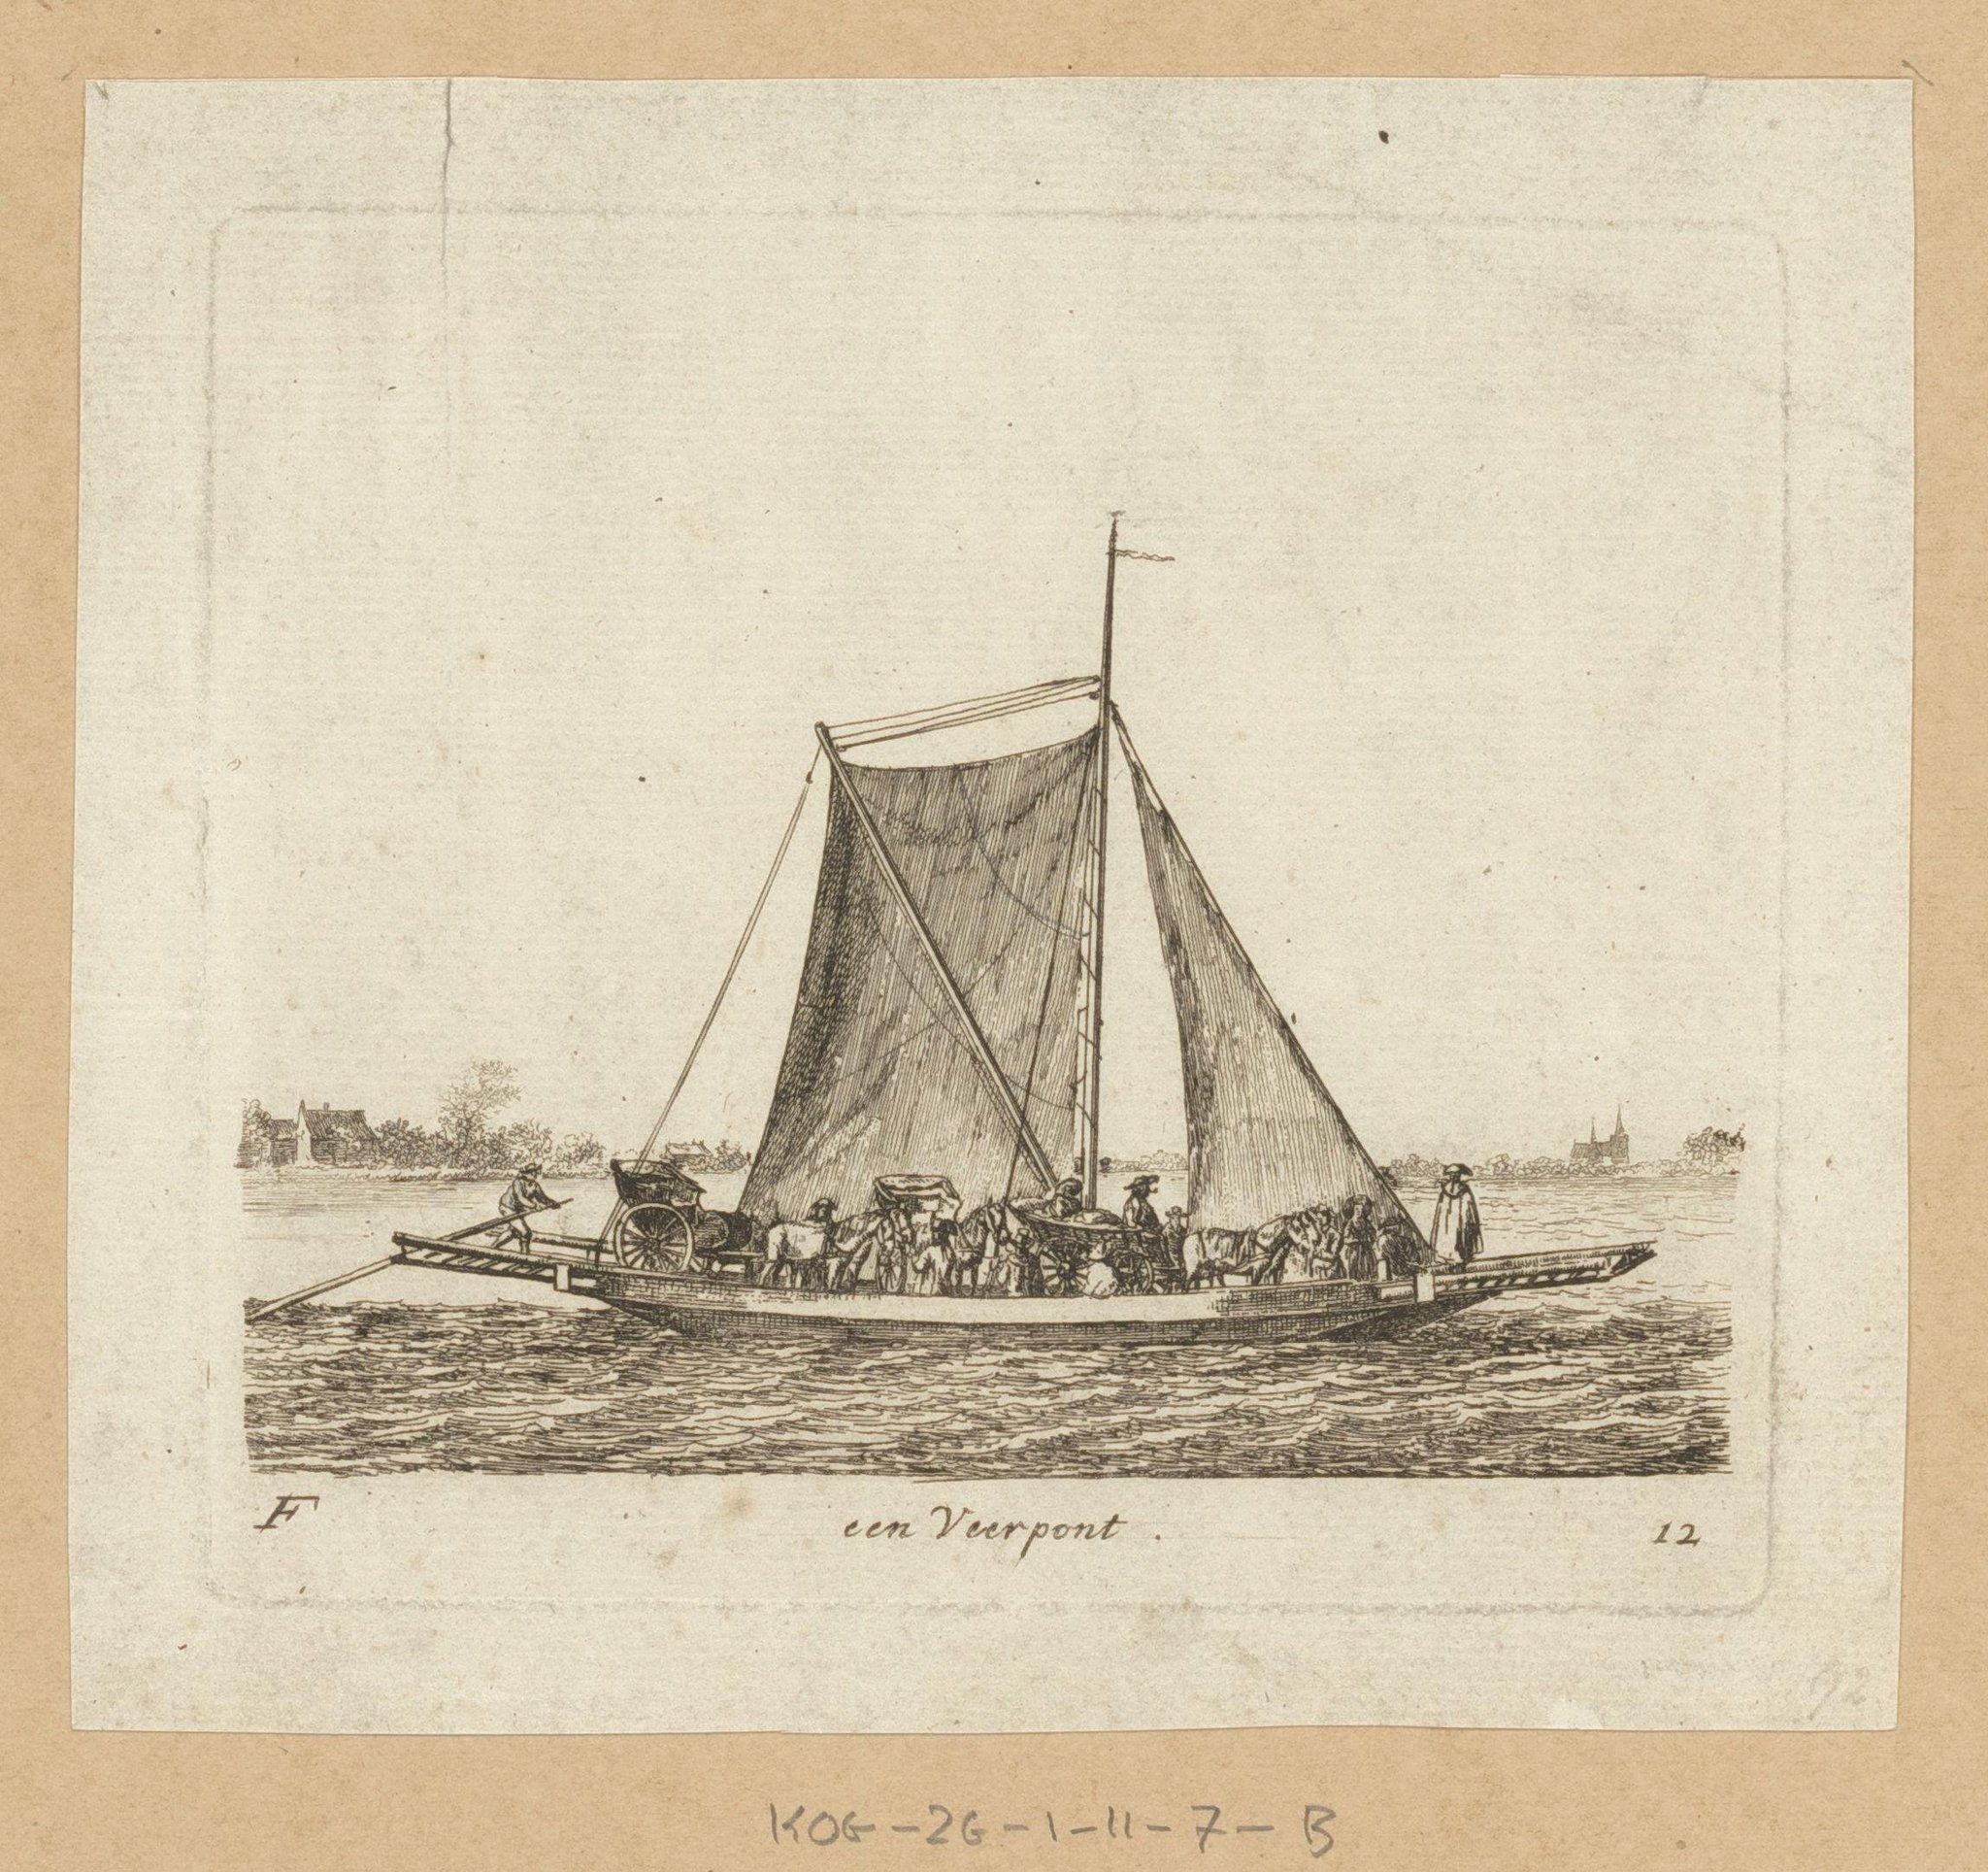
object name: print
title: Een Veerpont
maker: gerrit groenewegen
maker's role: draughtsman, print maker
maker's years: 1754-1826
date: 1791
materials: paper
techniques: etching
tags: two-wheeled, animal-drawn vehicle, four-wheeled, animal-drawn vehicle, e.g.: cab, carriage, coach, ferry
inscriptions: collector's mark: Lugt 1641, stamp, stamp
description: Meerdere paarden en wagens worden overgezet door een zeilboot. Rechtsonder: F en linksonder genummerd: 12. Onderwerpsrubrieken binnen de Atlas Zeden en Gewoonten: Handel, nijverheid en verkeer, Vervoermiddelen te land en te water, Vervoermiddelen te water.